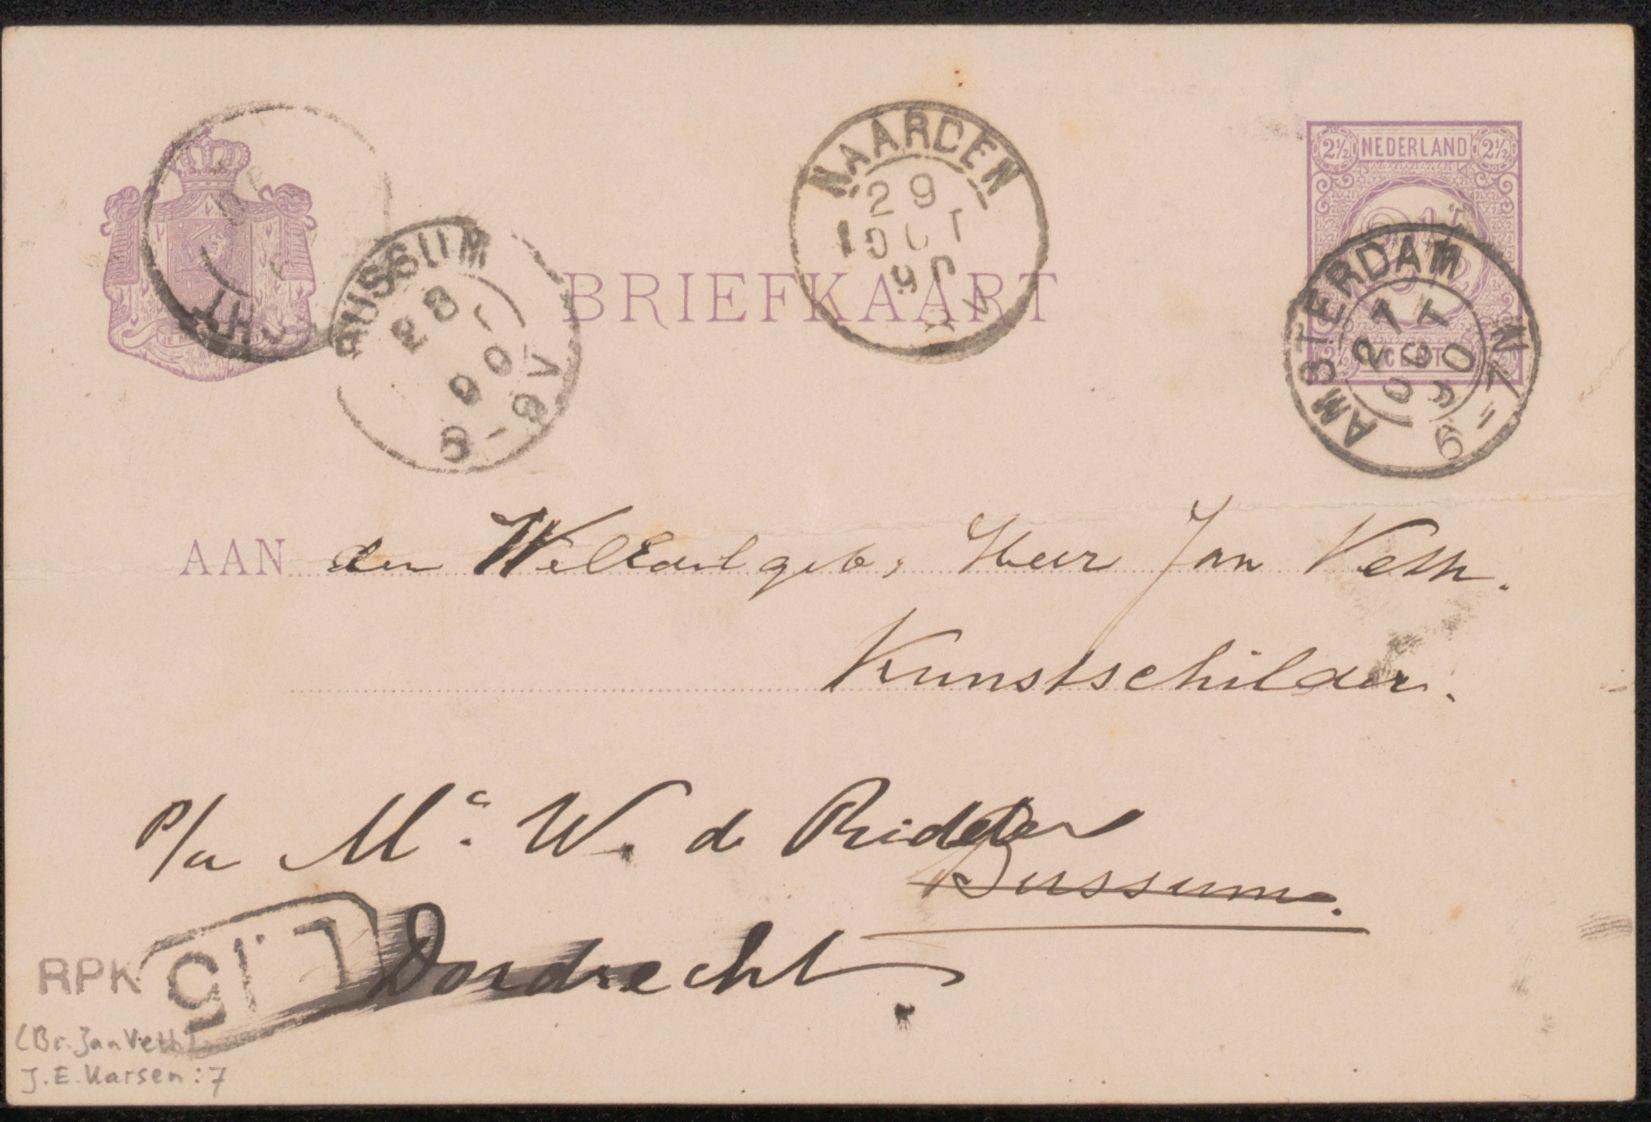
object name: postcard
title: Briefkaart aan Jan Veth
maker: eduard karsen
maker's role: draughtsman, painter, print maker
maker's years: 1860-1941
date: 1890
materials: cardboard, ink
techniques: pen, writing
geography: amsterdam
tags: dordrecht, designer, jan veth, amsterdam, print maker, draughtsman, marius bauer, the graphic arts, painting (including book-illumination, miniature-painting), exhibition ~ art, historical persons (portraits and scenes from the life), new york (city)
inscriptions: collector's mark: ‘RPK’